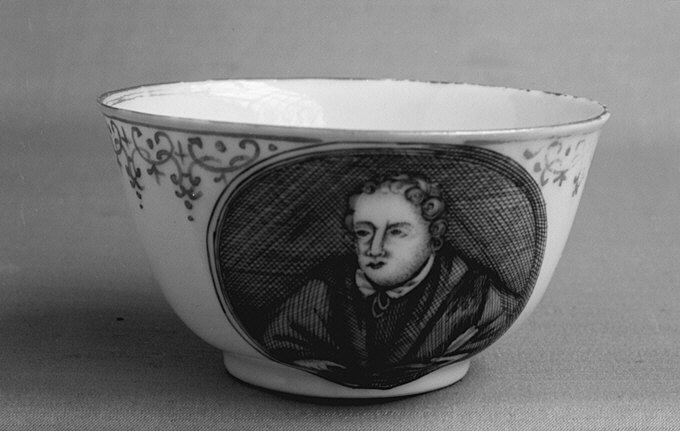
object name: teabowl and saucer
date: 1740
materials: hard paste porcelain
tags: men,portraits